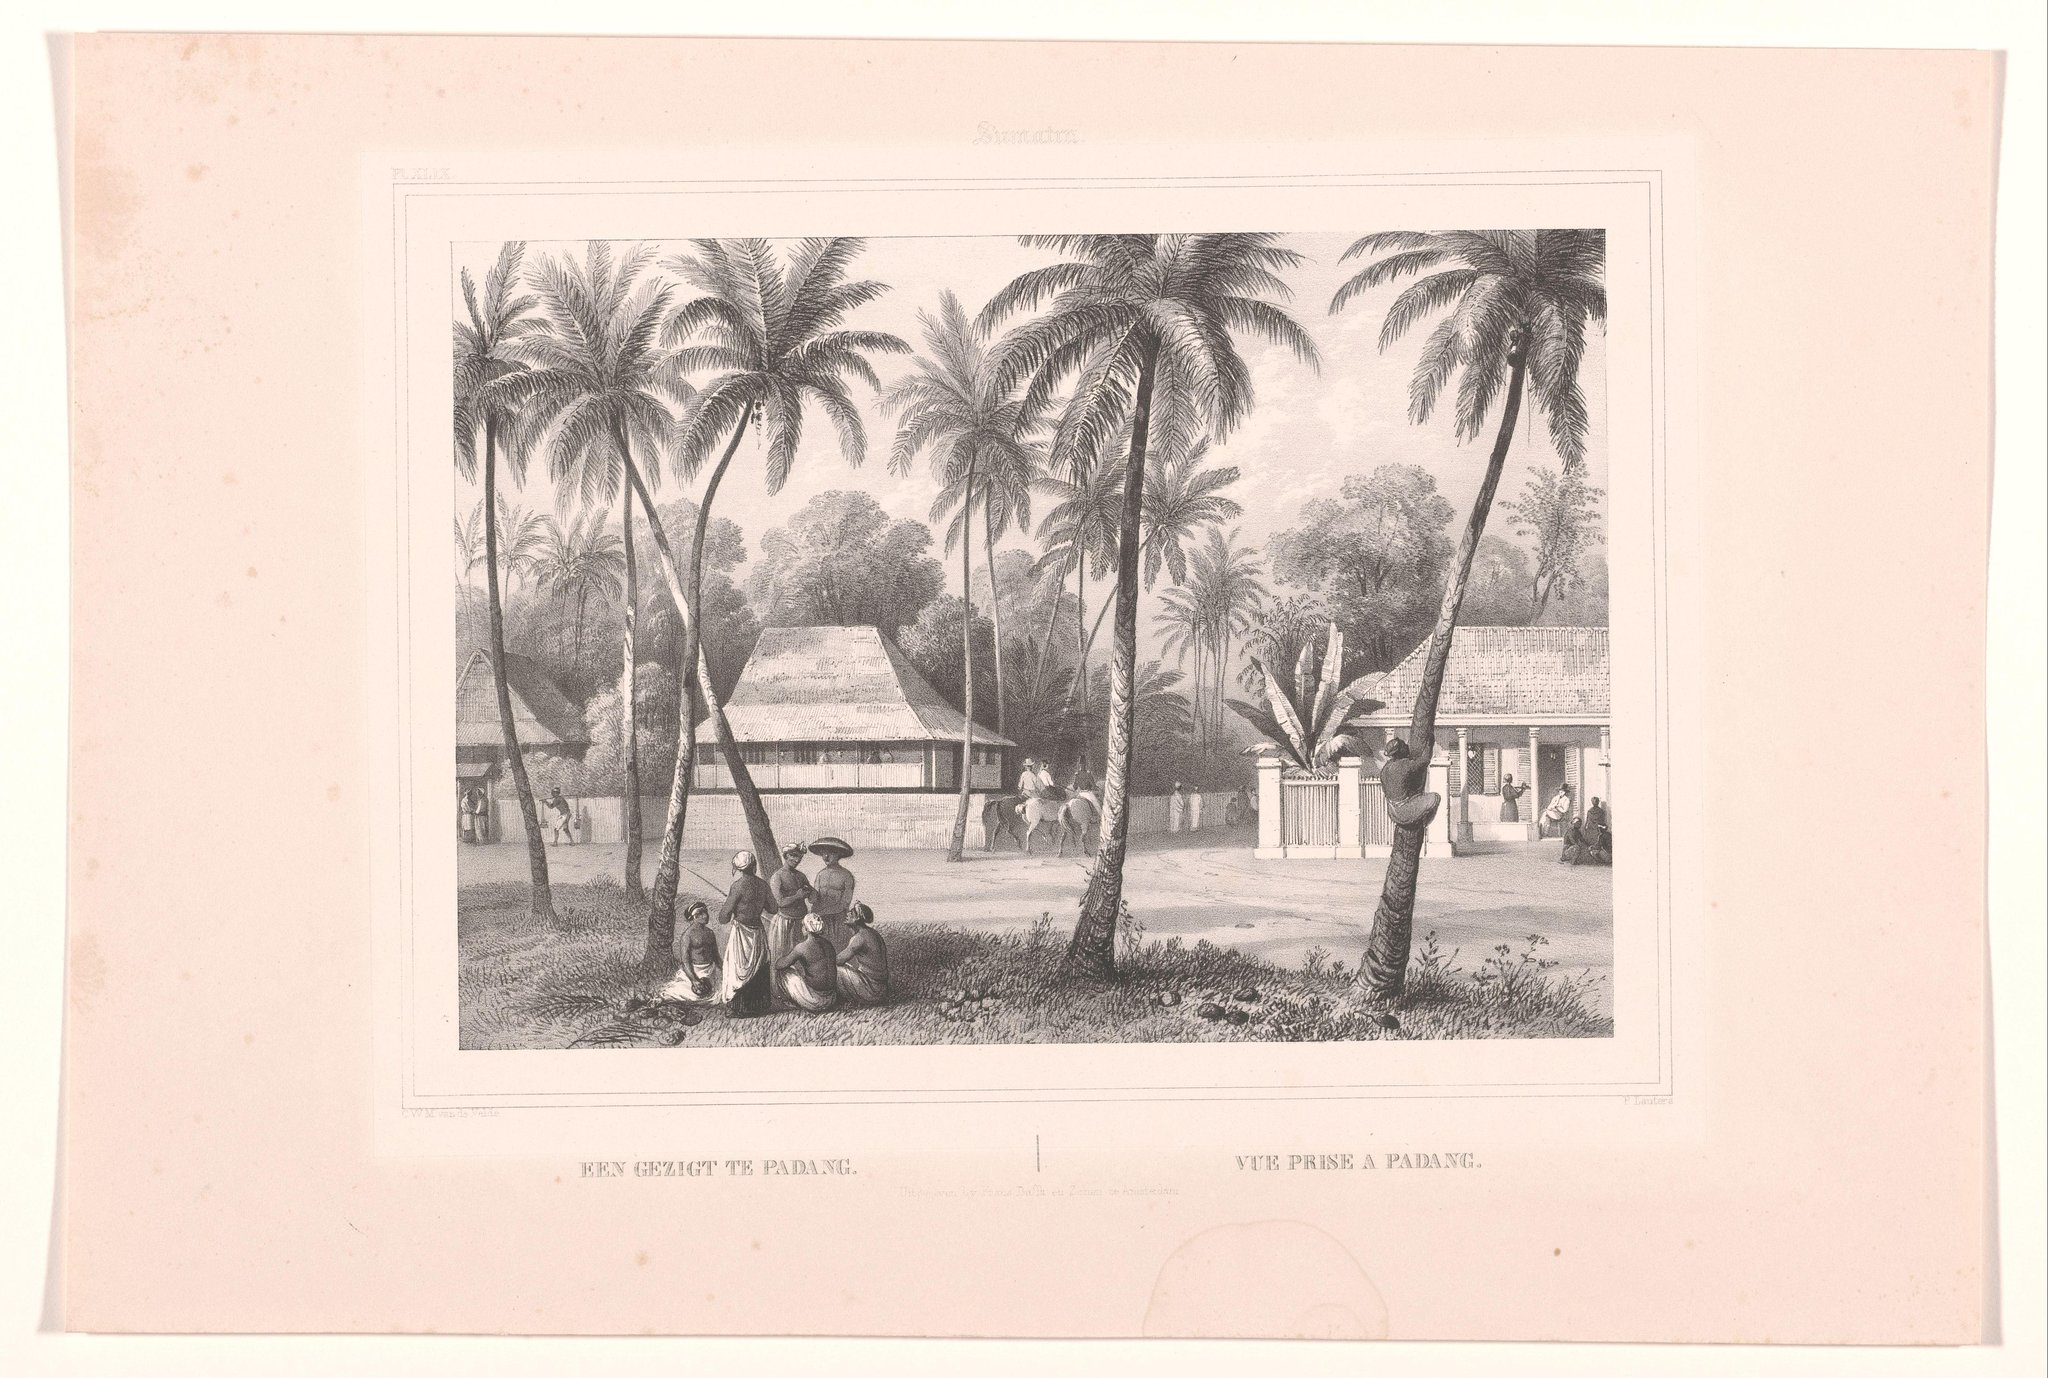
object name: print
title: Sumatra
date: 1843-1845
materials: paper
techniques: lithograph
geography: indonesia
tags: landscapes in the non-temperate zone, exotic landscapes, climbing up a tree, street (+ city(-scape) with figures, staffage)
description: Tussen de bomen staan en zitten mannen bij elkaar. Rechts klimt een man in een palmboom. Genummerd linksboven: Pl. XLIX. De prent maakt deel uit van een omslag met zeven bladen.